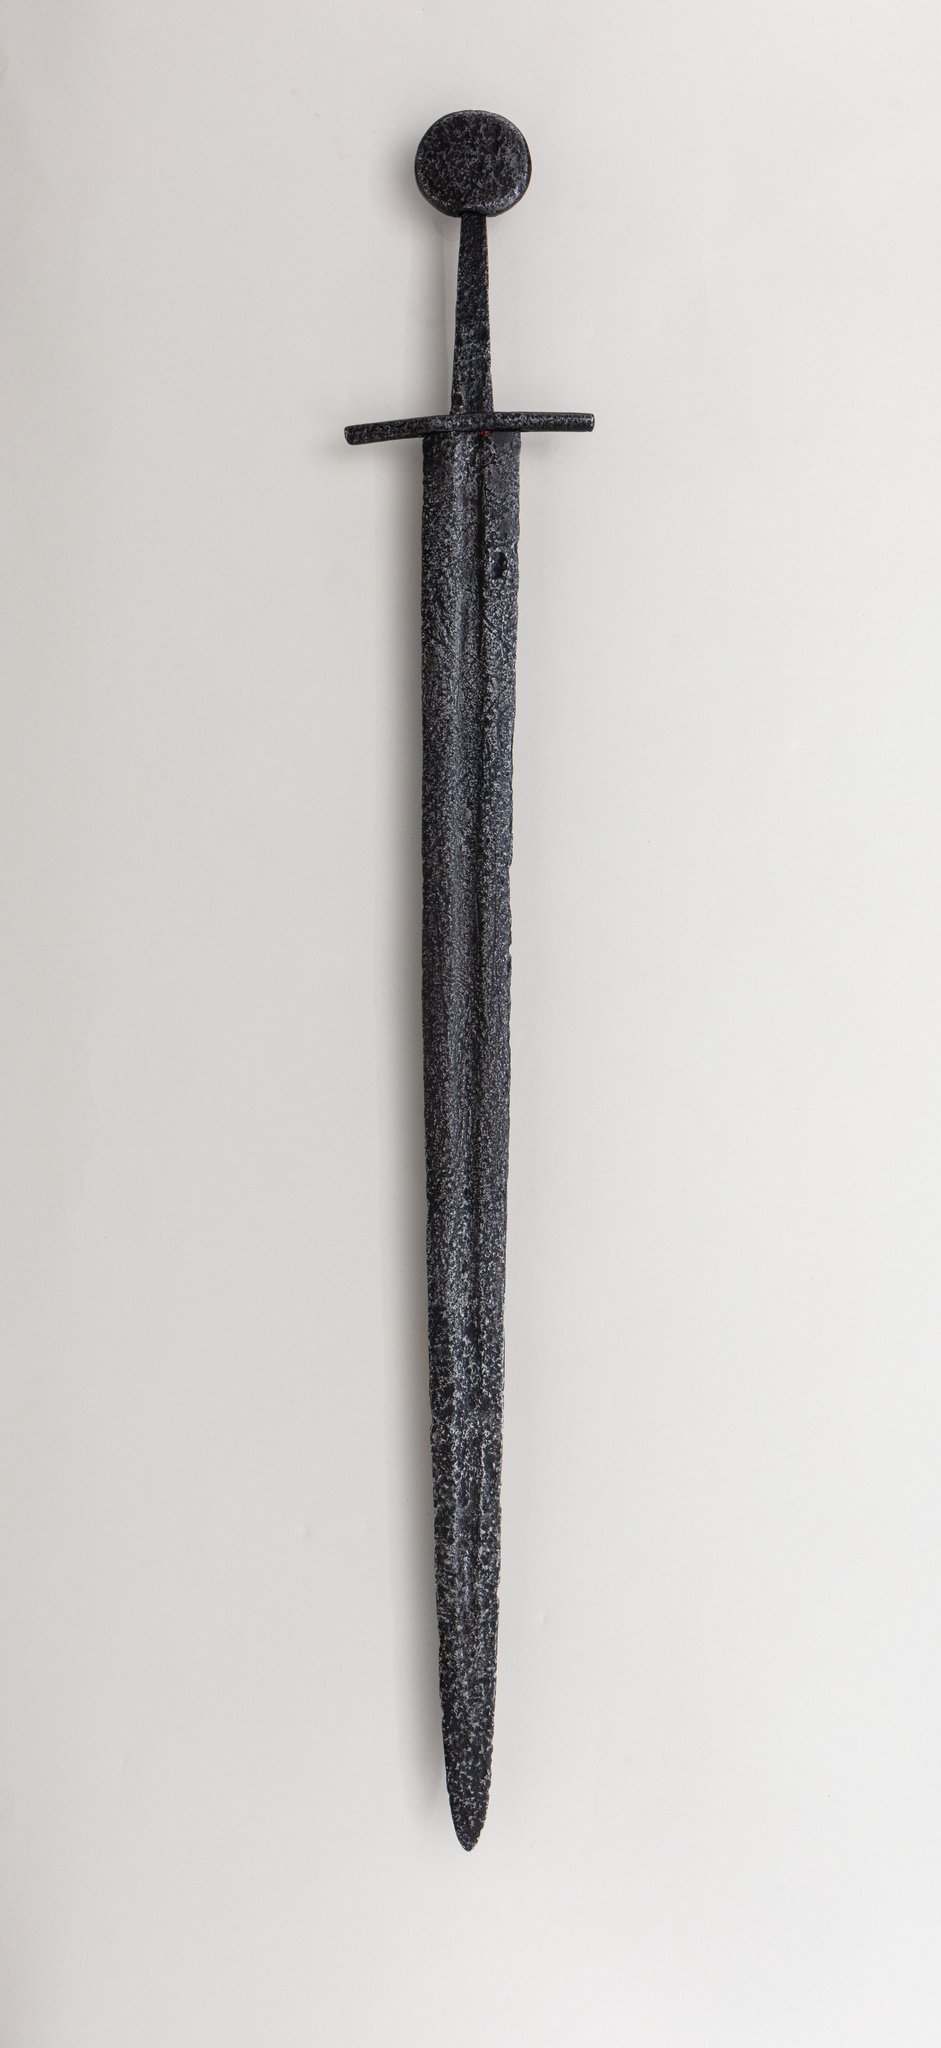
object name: sword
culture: french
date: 1201-1300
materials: iron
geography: france